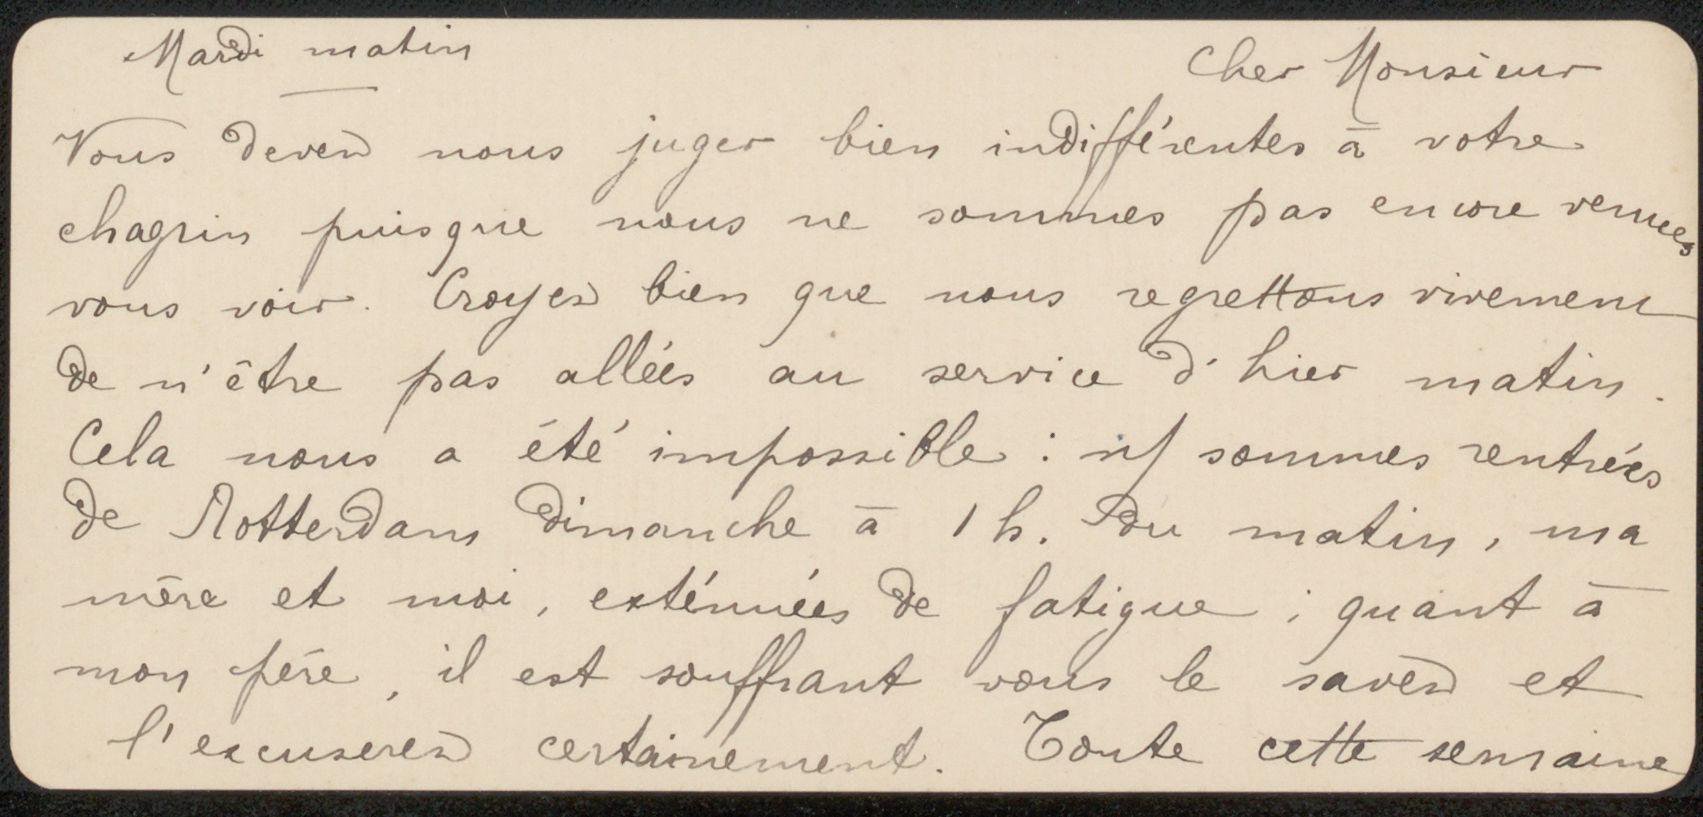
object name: letter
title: Brief aan Philip Zilcken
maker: marguerite picard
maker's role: zangeres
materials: ink, paper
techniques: pen, writing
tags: voorburg, renée hélène laure zilcken, the hague, painter, draughtsman, philip zilcken